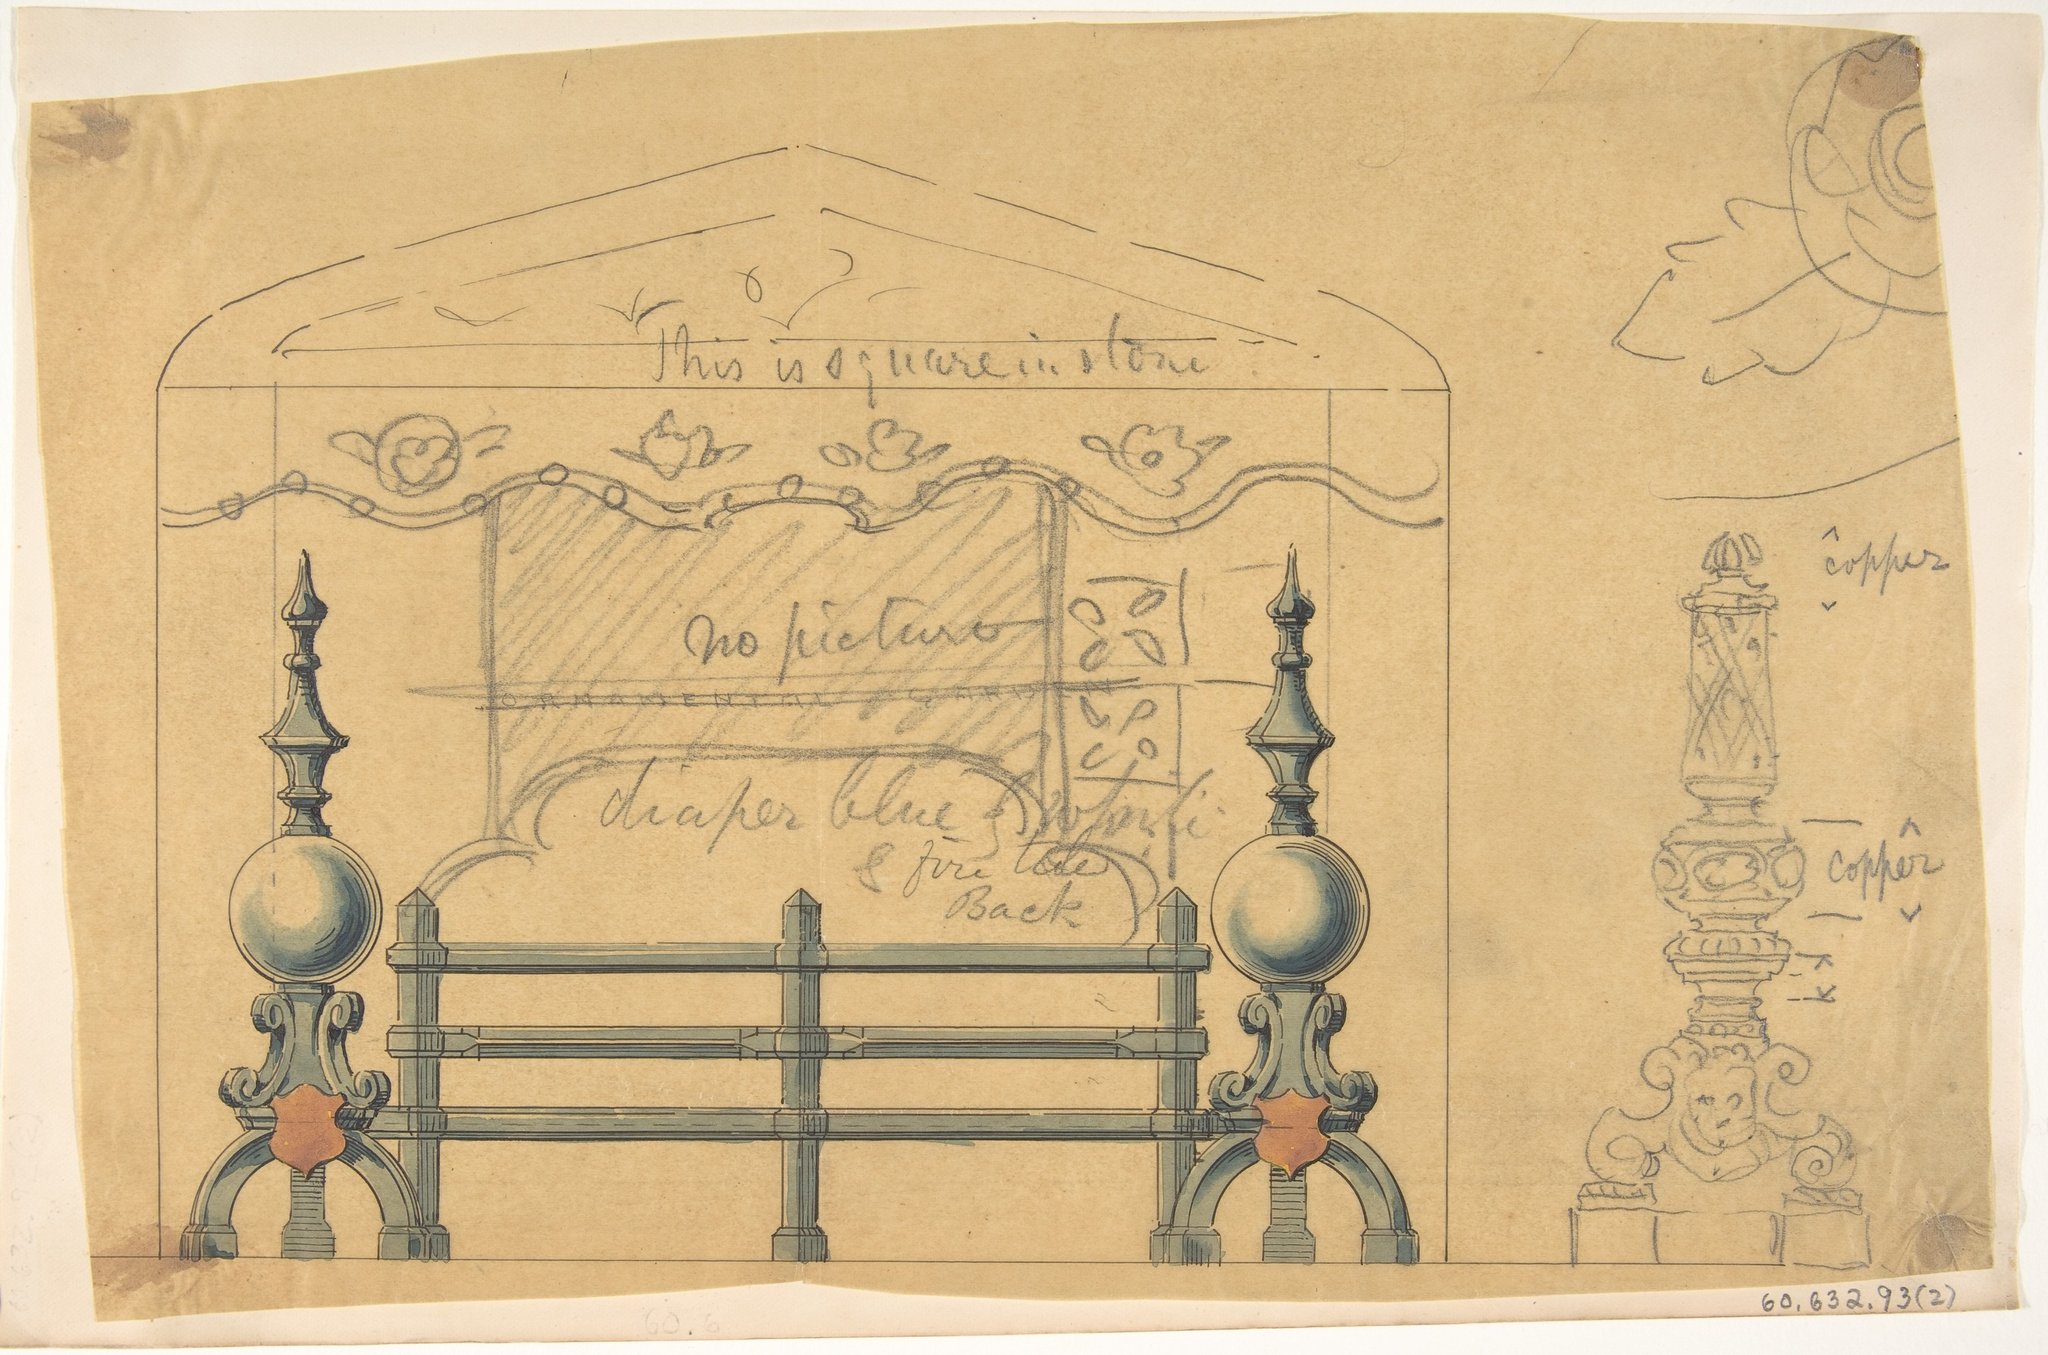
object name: drawing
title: Design for Grate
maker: anonymous, british, 19th century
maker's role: artist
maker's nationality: british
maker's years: 1800-1900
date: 1874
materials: graphite, ink, watercolor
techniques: pen